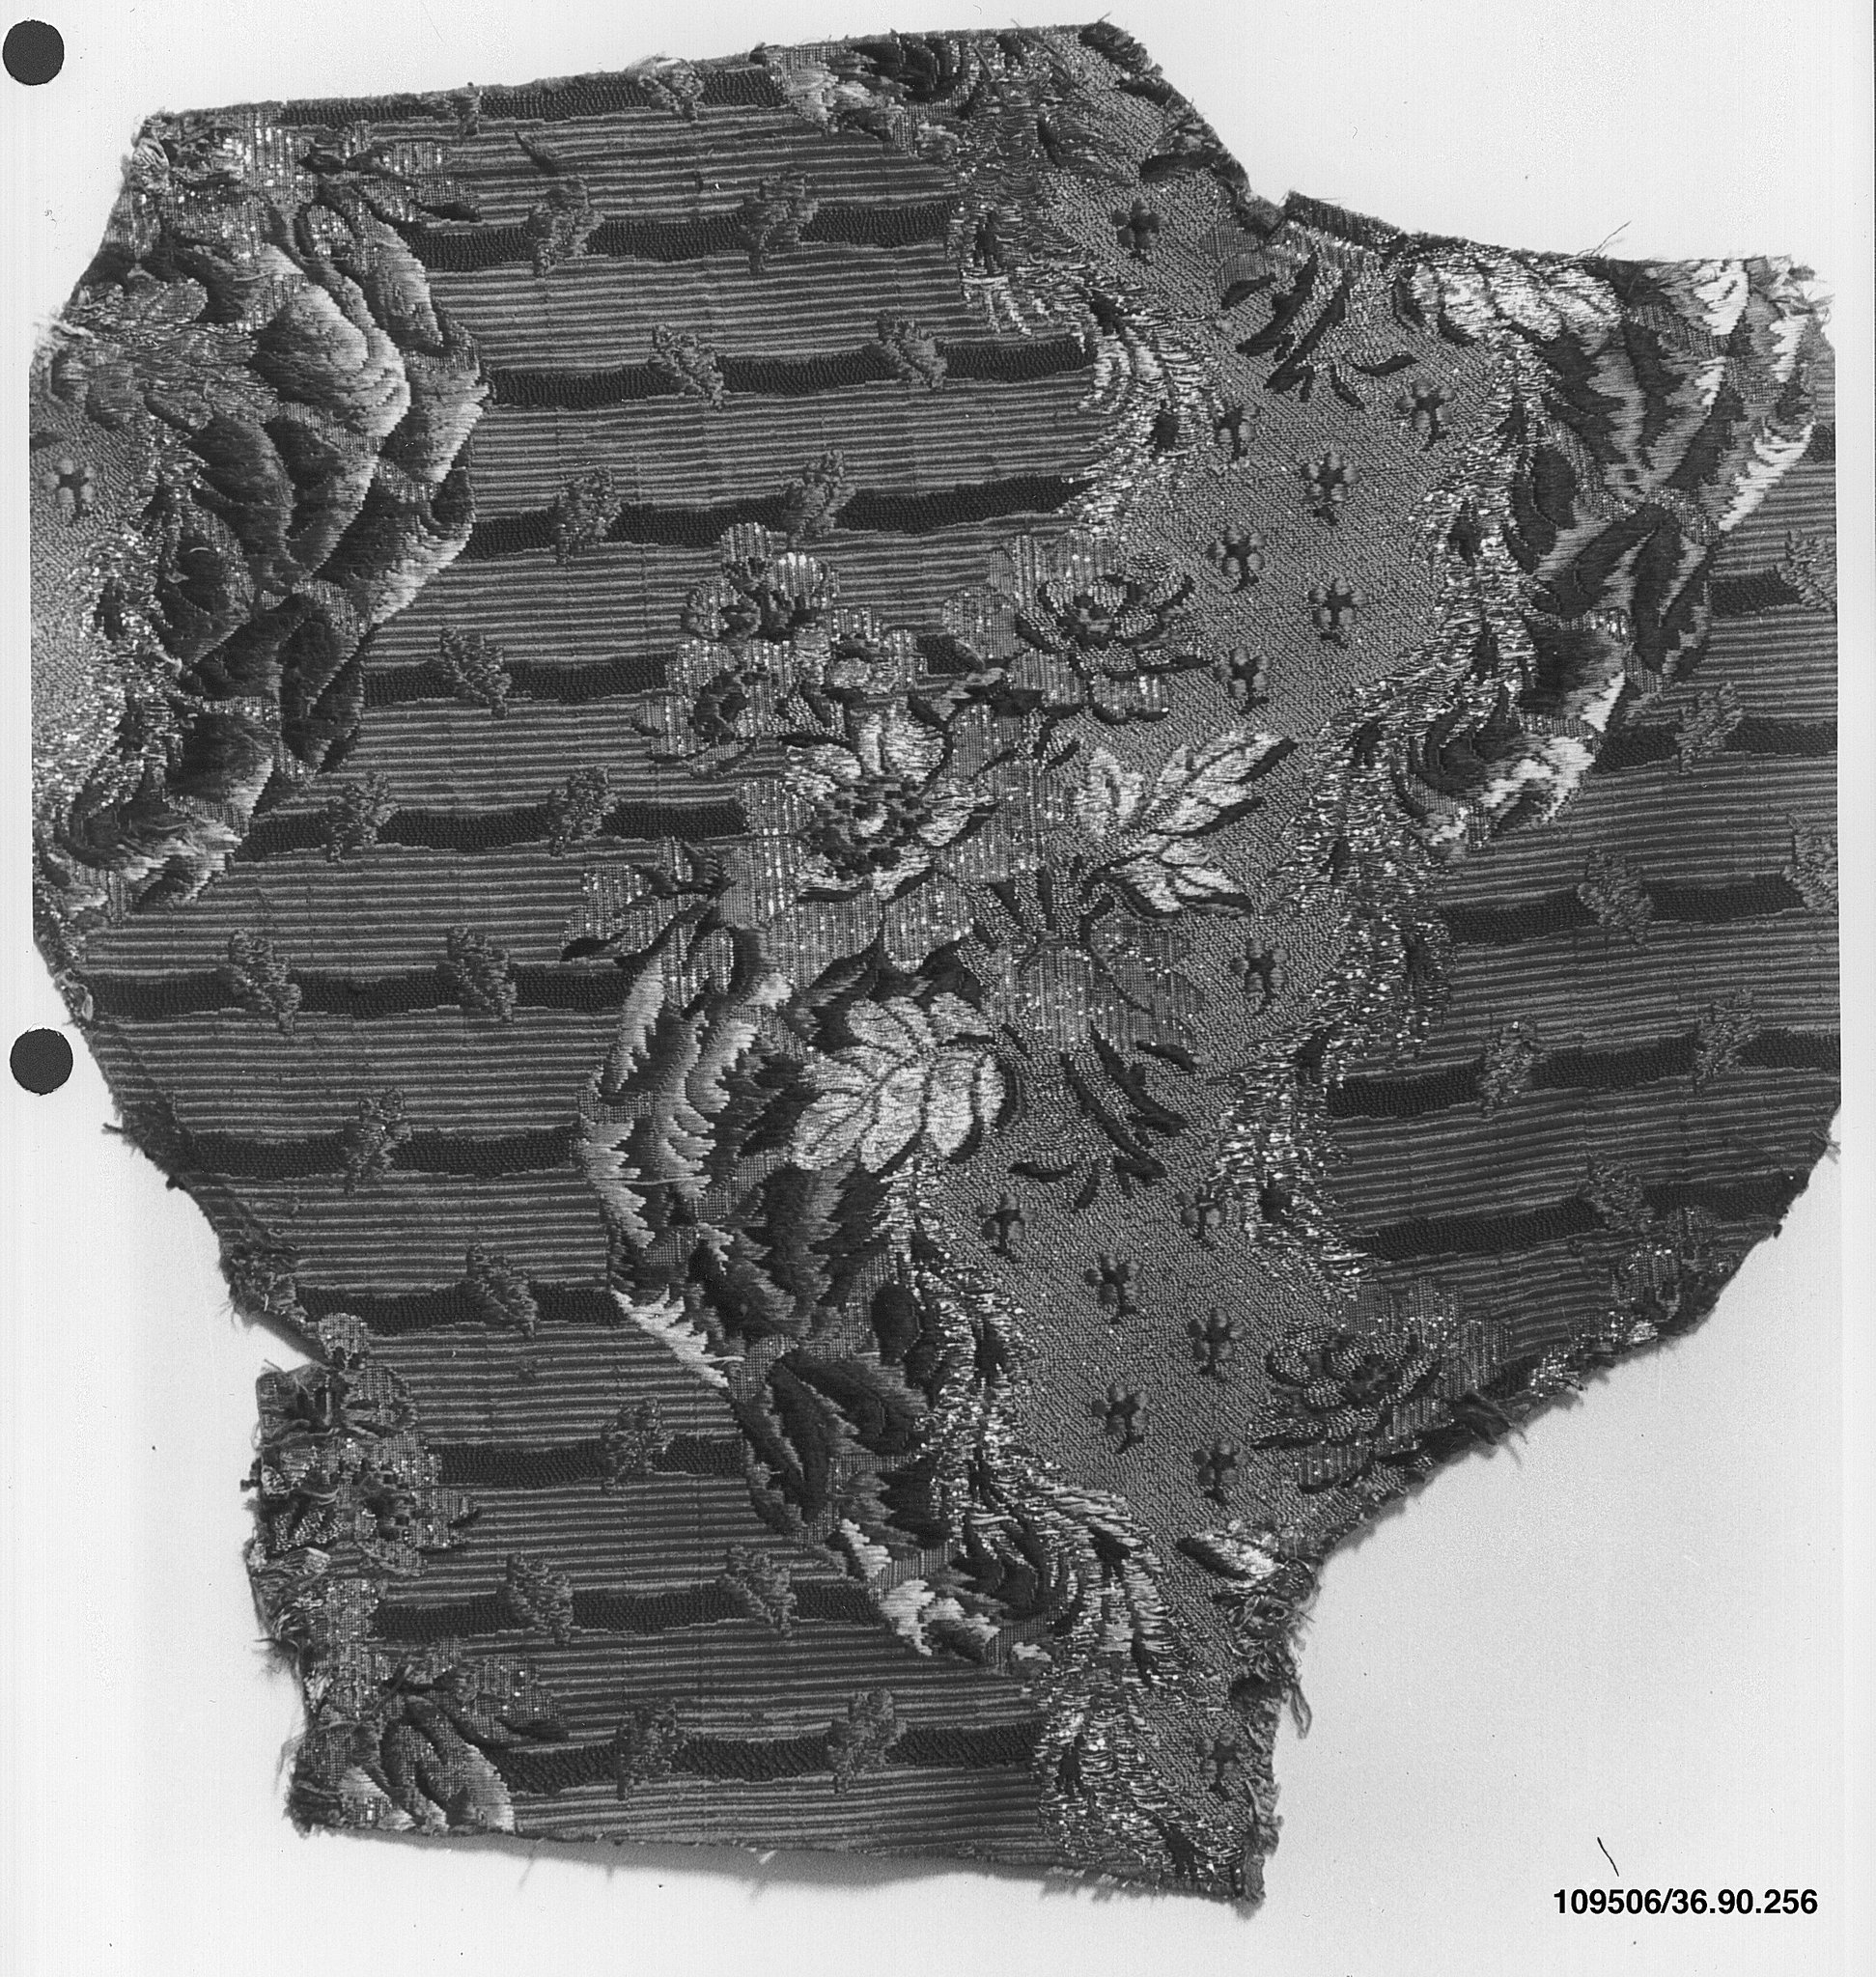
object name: piece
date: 1760-1770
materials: metal thread, silk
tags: flowers,leaves